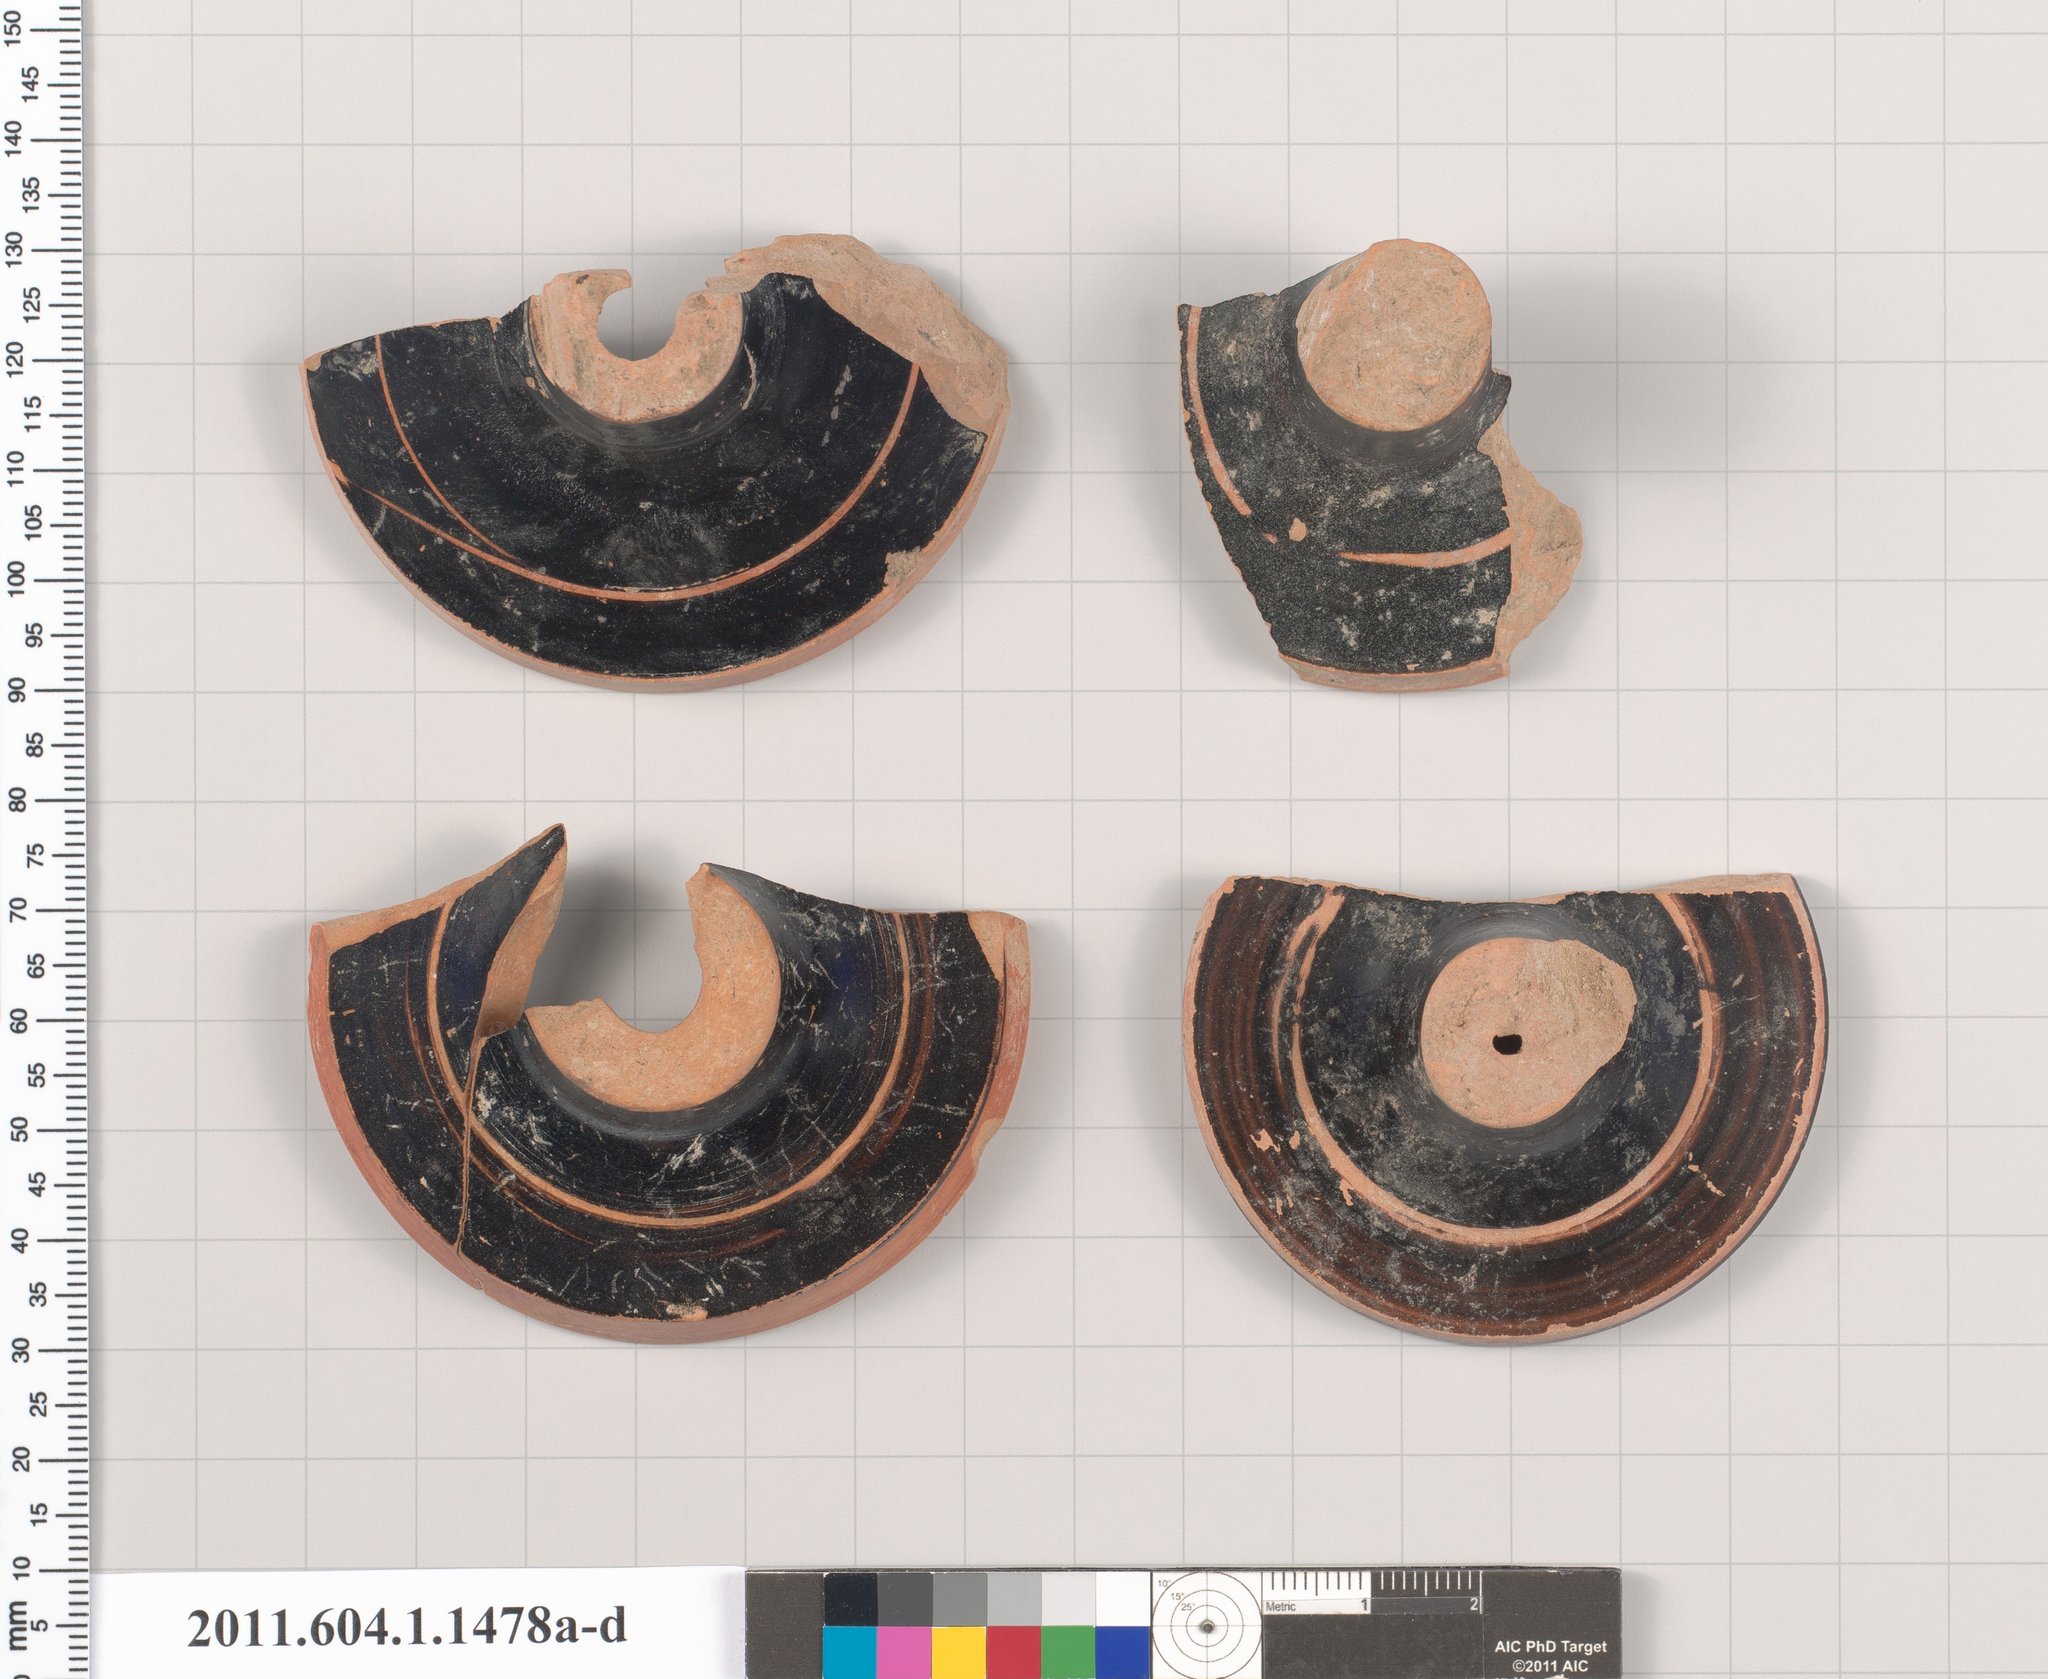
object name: kylix fragment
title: Terracotta fragments of kylikes (drinking cups)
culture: greek, attic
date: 500-401 BCE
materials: terracotta